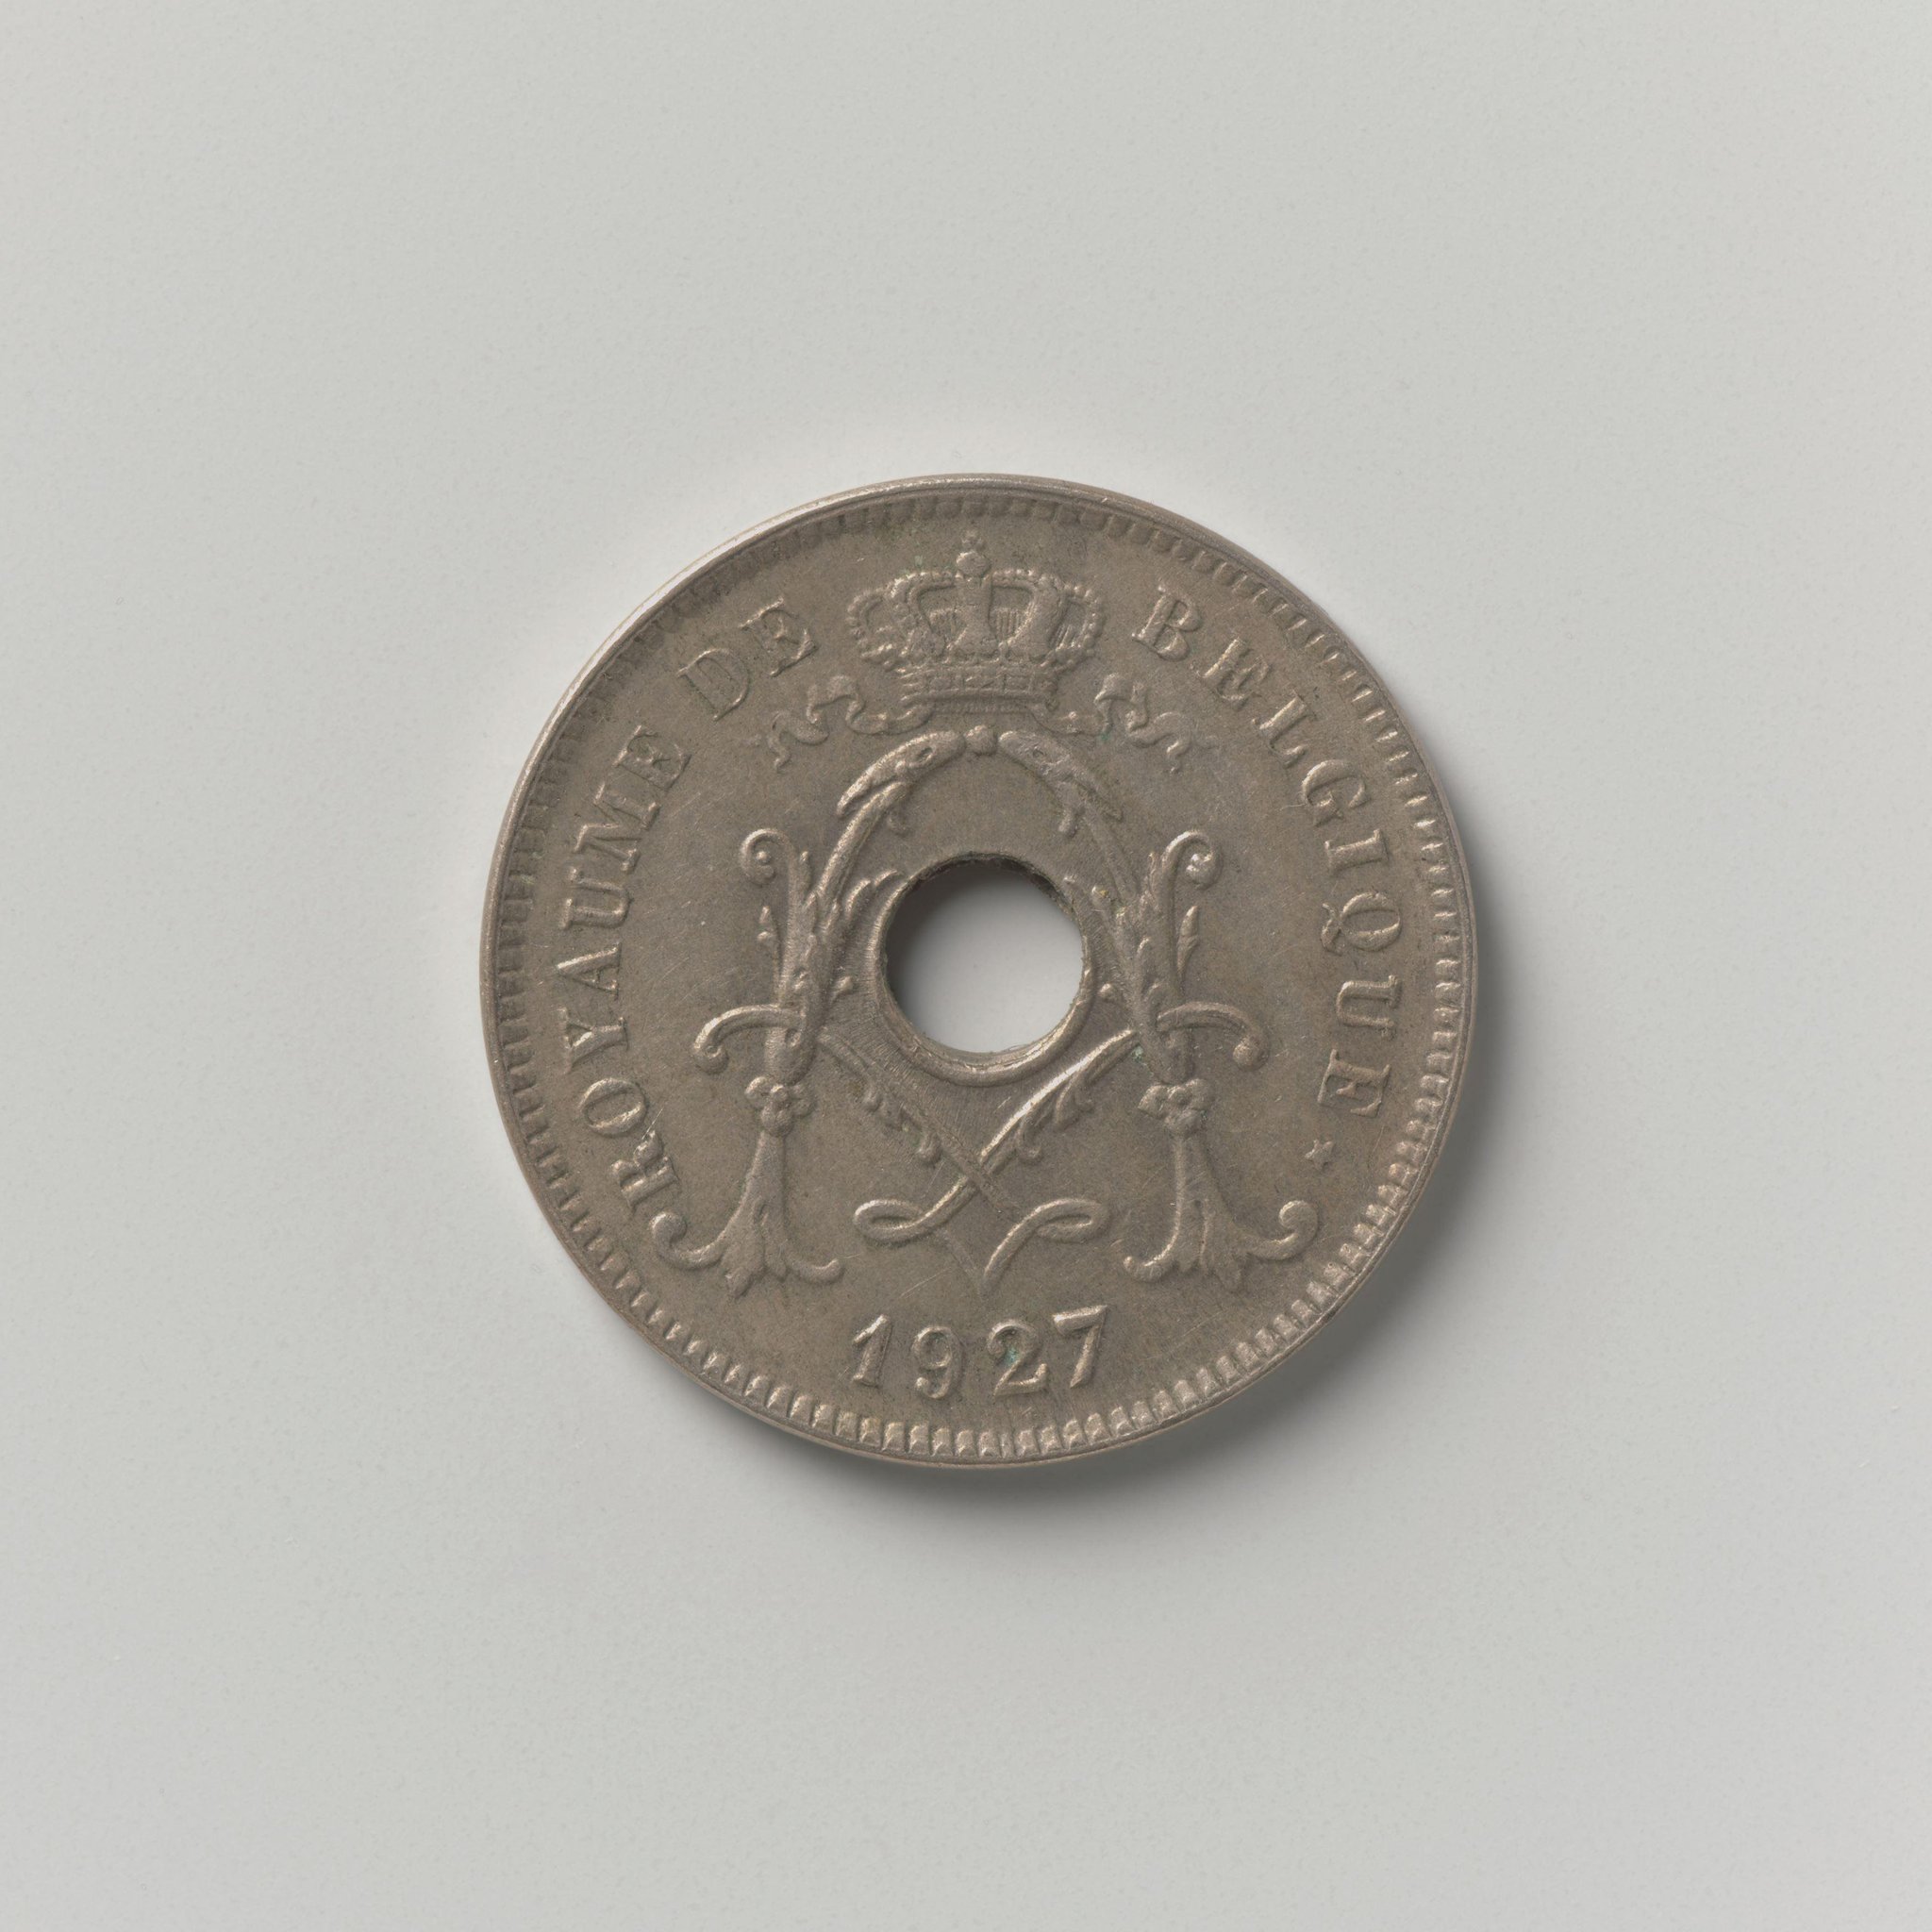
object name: tien centime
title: 10 centimes uit België van Leopold II, 1907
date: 1907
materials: nickel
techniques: striking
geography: brussels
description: Nikkelen munt. Voorzijde: gekroond monogram van twee letters L. Jaaartal onderaan. Keerzijde: rechts van gebogen lauwertak waarde-aanduiding 10 Ces. Centrale doorboring. Gladde rand.